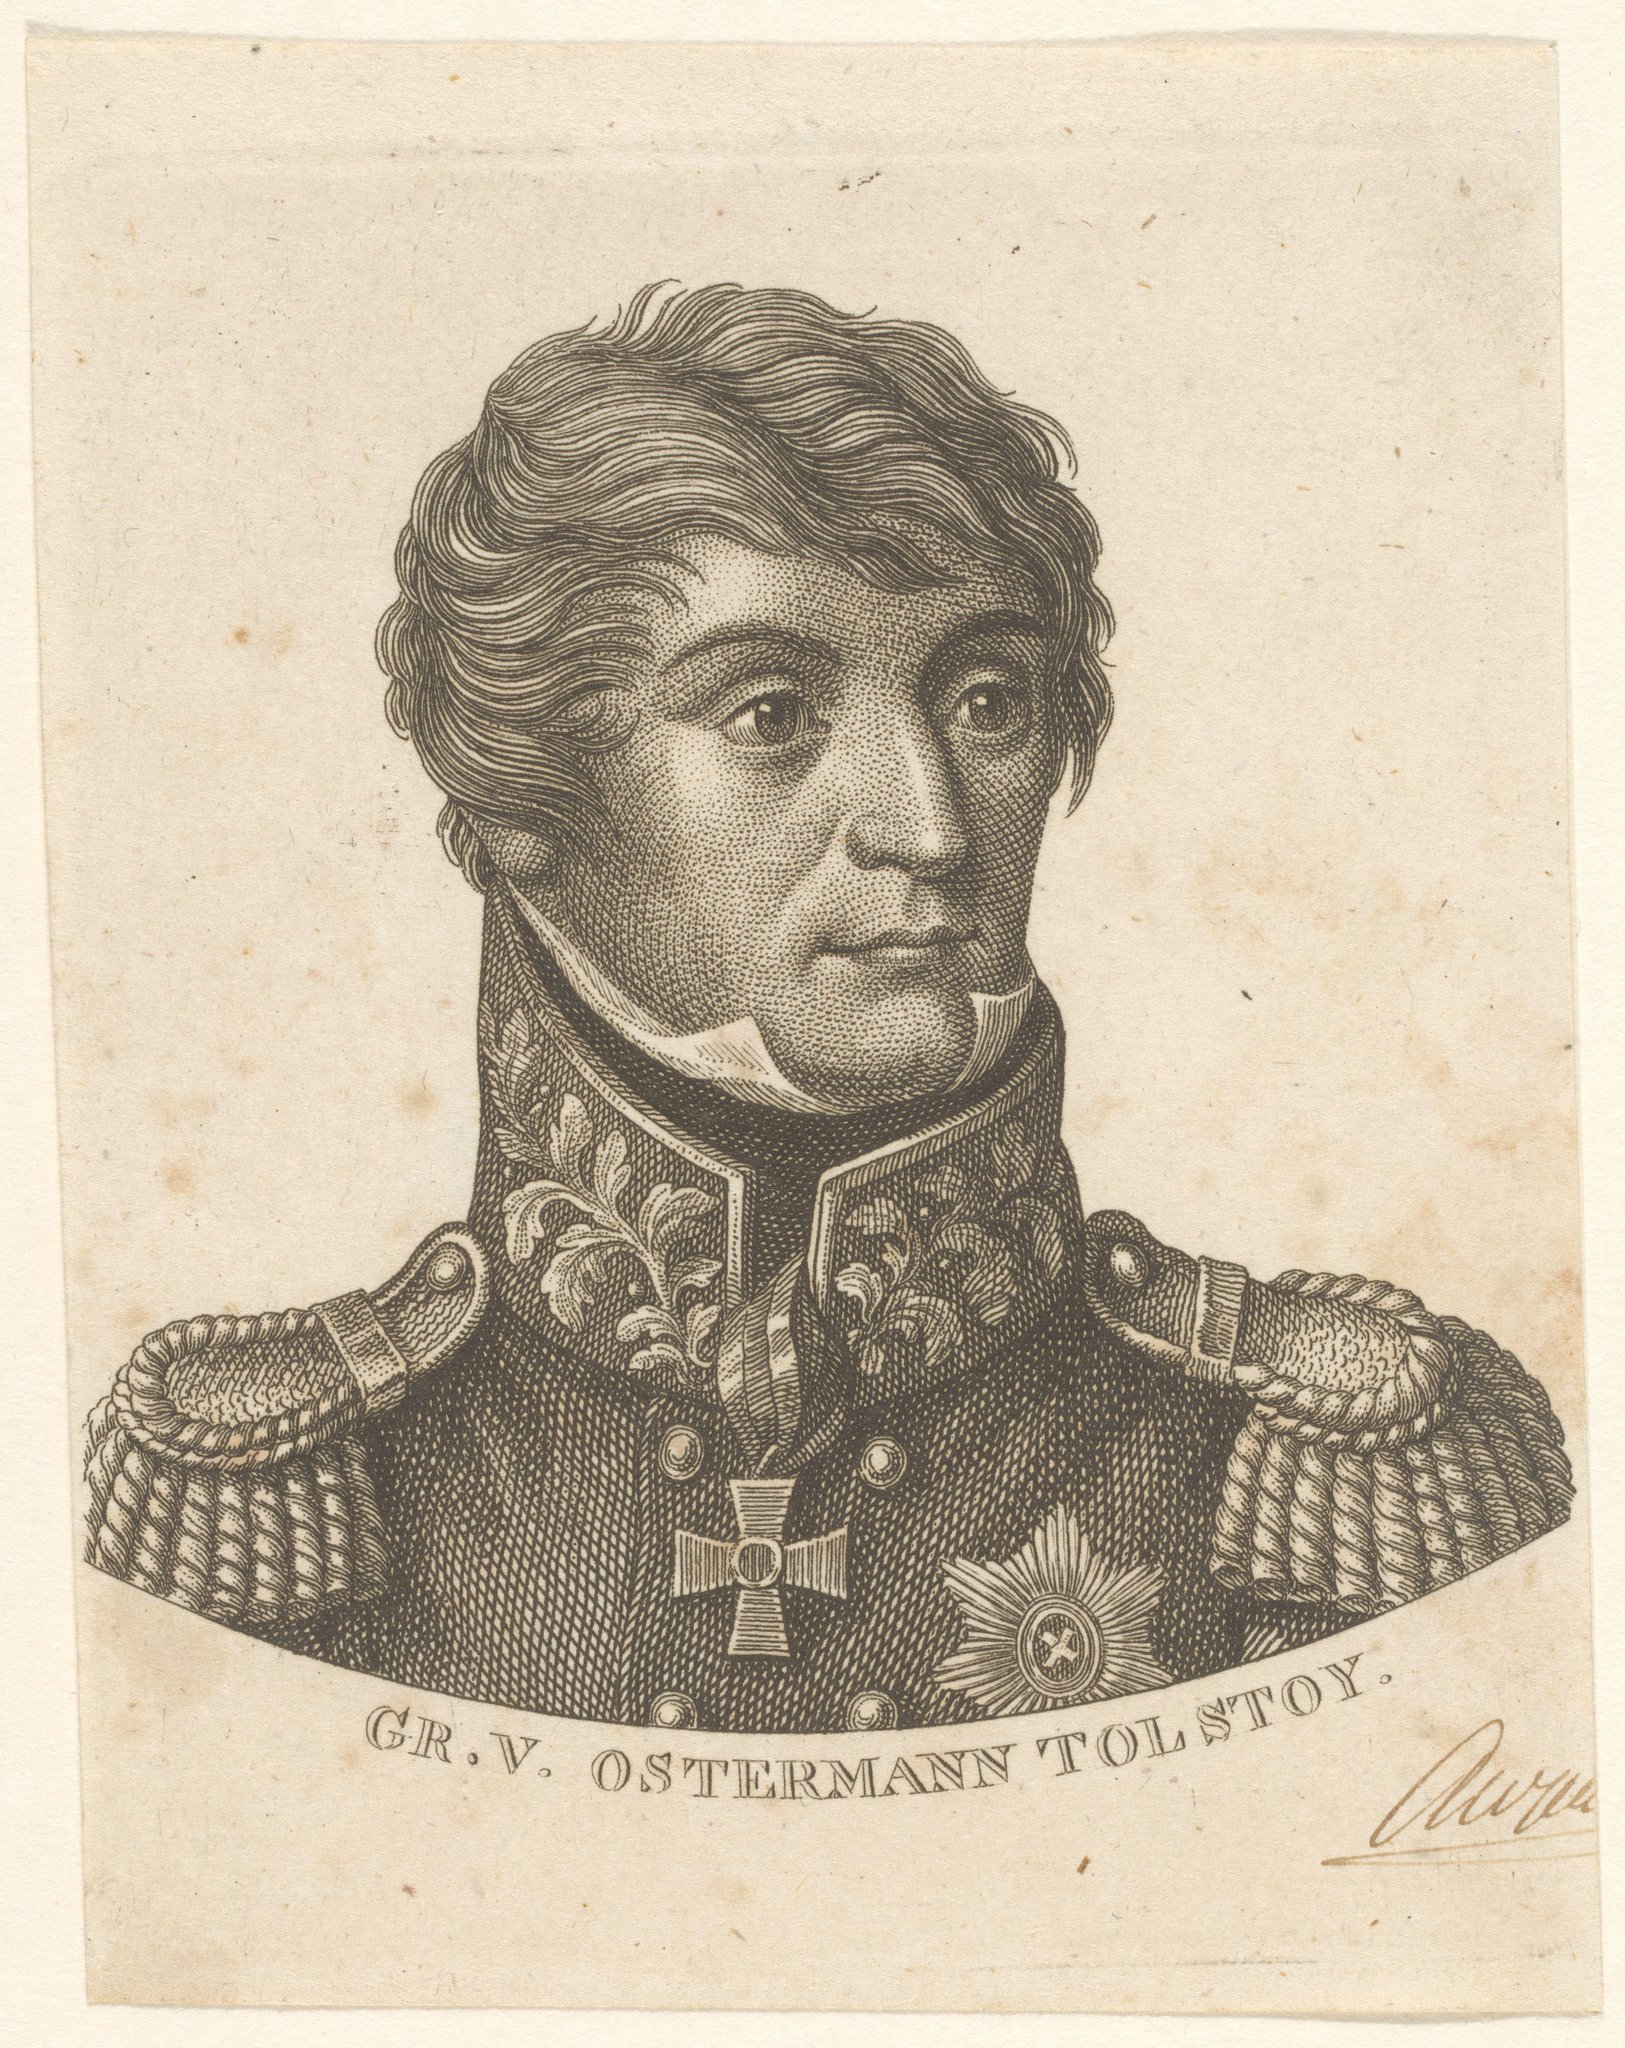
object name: print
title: Portret van Aleksandr Iwanowitsch, graaf Ostermann-Tolstoj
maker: ernst ludwig riepenhausen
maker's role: print maker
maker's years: 1765-1840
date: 1775-1840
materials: paper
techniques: engraving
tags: historical persons, medals and other marks of military honour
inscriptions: collector's mark: Lugt 2228, name